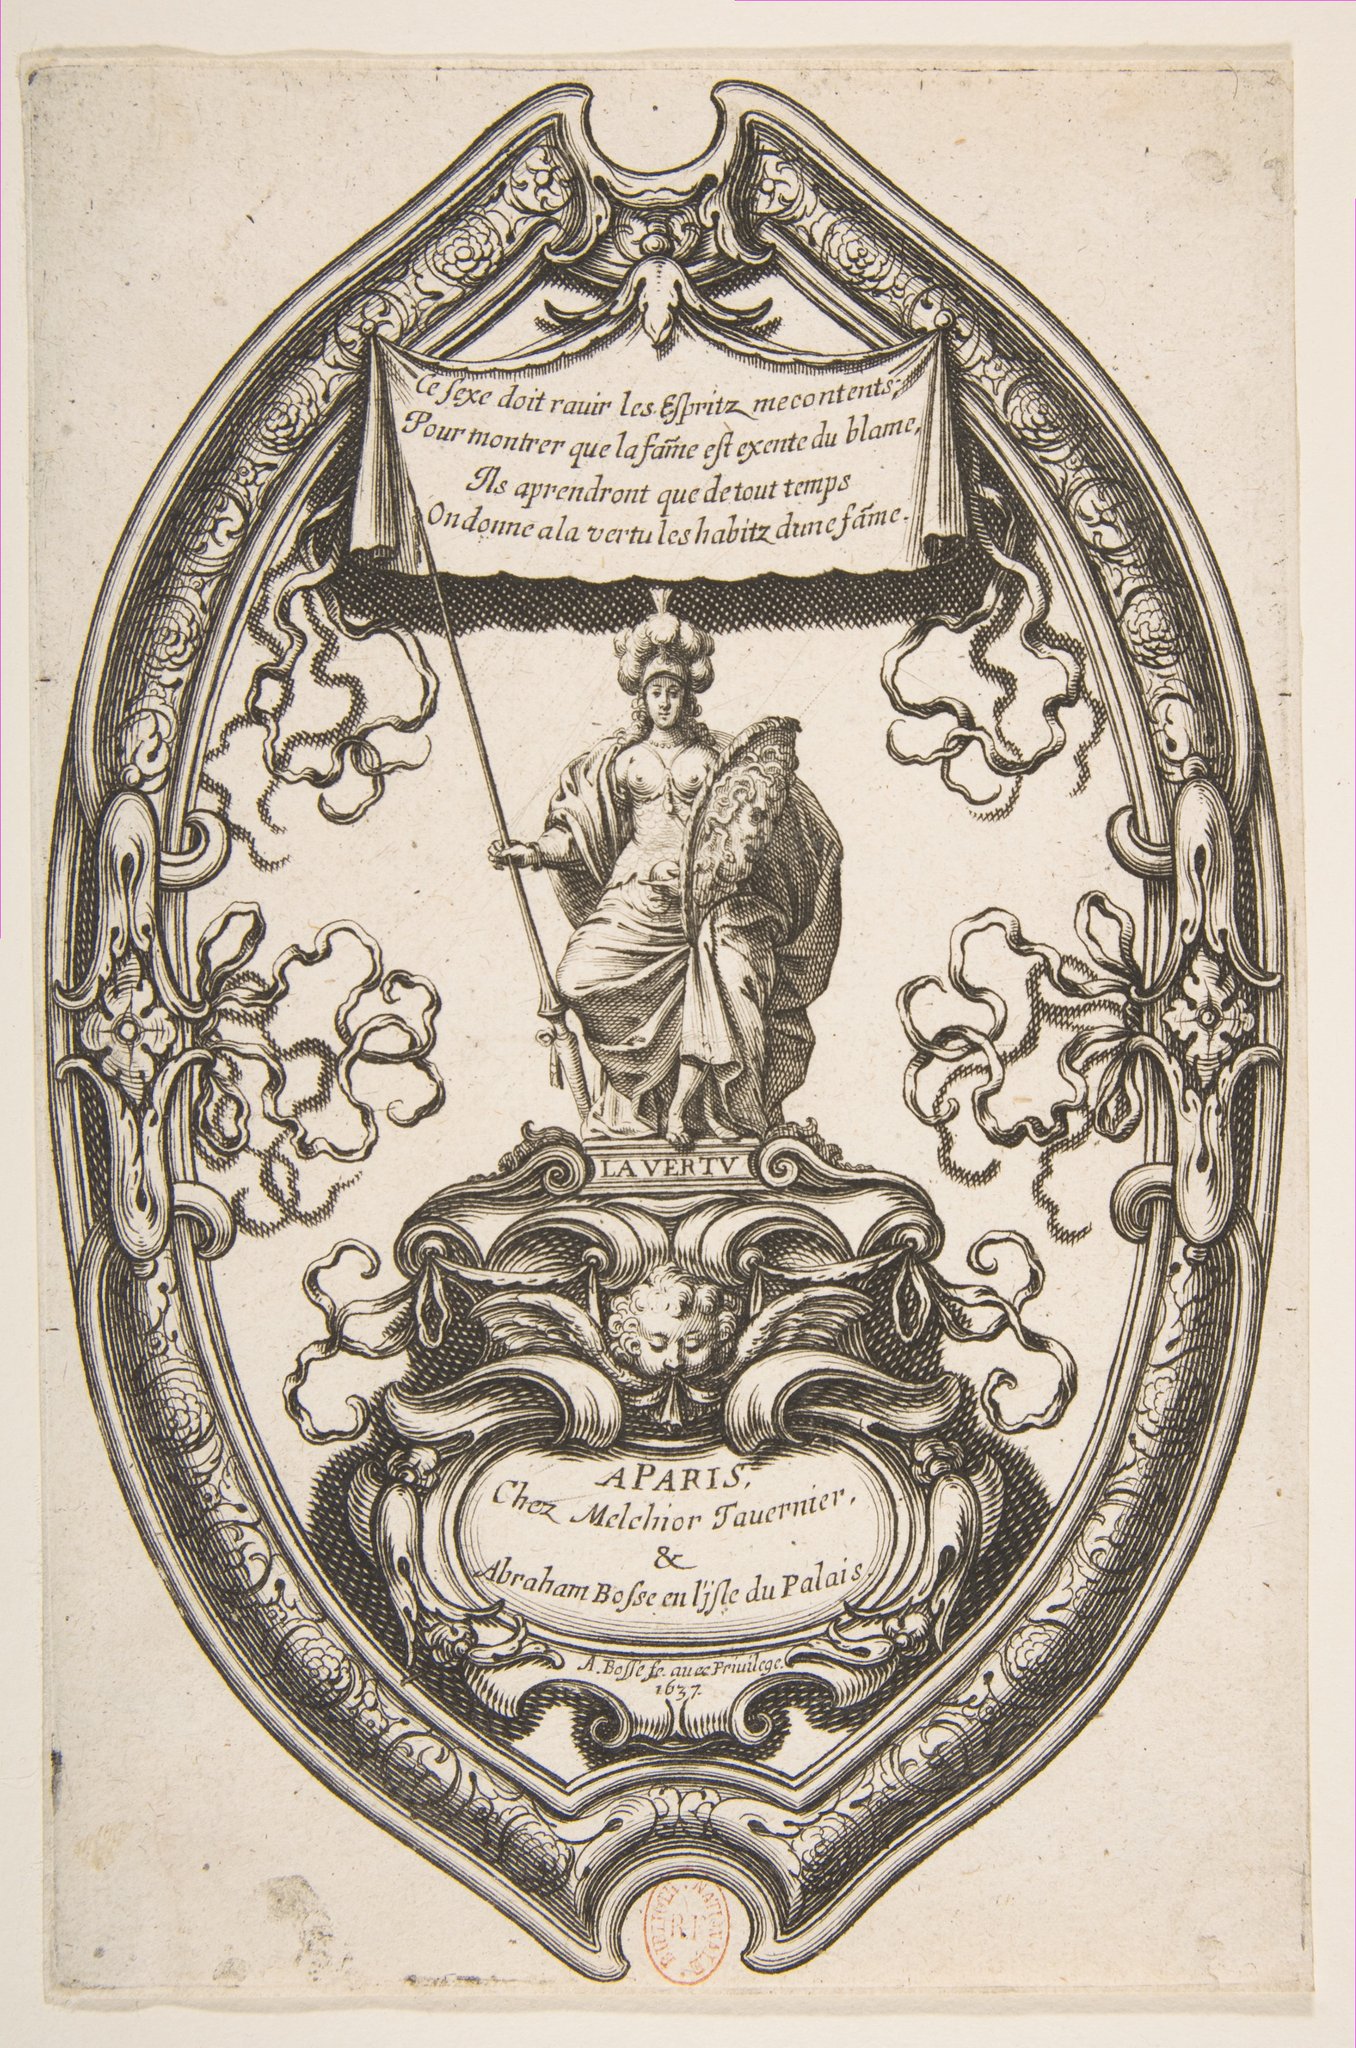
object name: print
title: Virtue: Athena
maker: abraham bosse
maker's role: artist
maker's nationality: french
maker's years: 1602-1676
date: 1637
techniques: etching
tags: shields,faces,athena